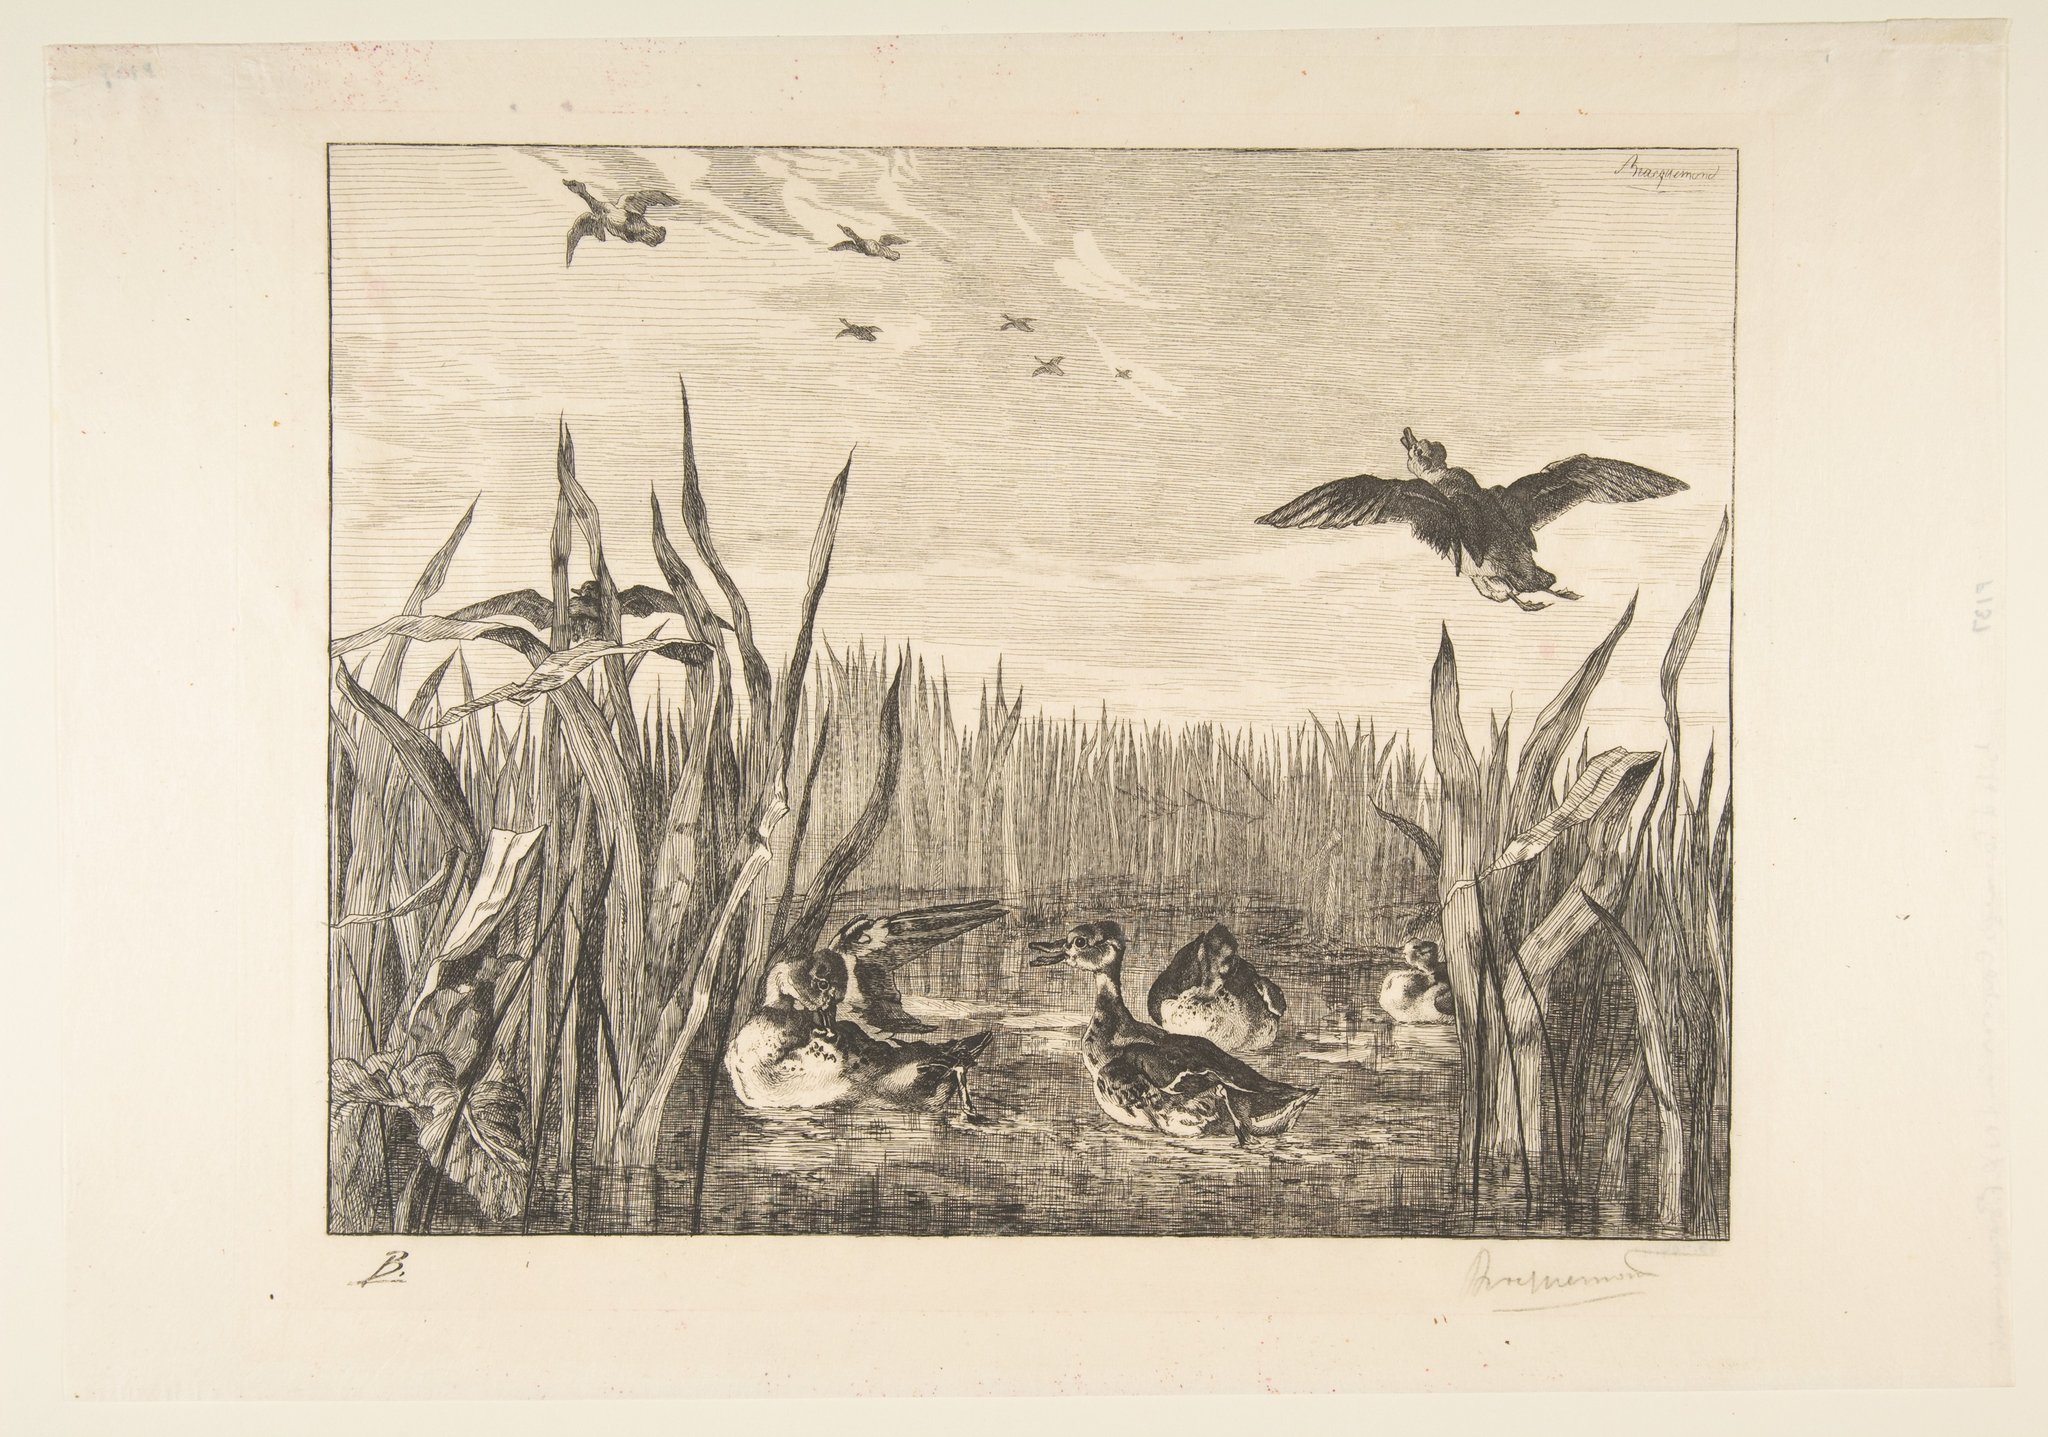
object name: print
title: Sarcelles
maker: félix bracquemond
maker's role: artist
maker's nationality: french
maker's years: 1833-1914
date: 1853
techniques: etching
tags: ducks